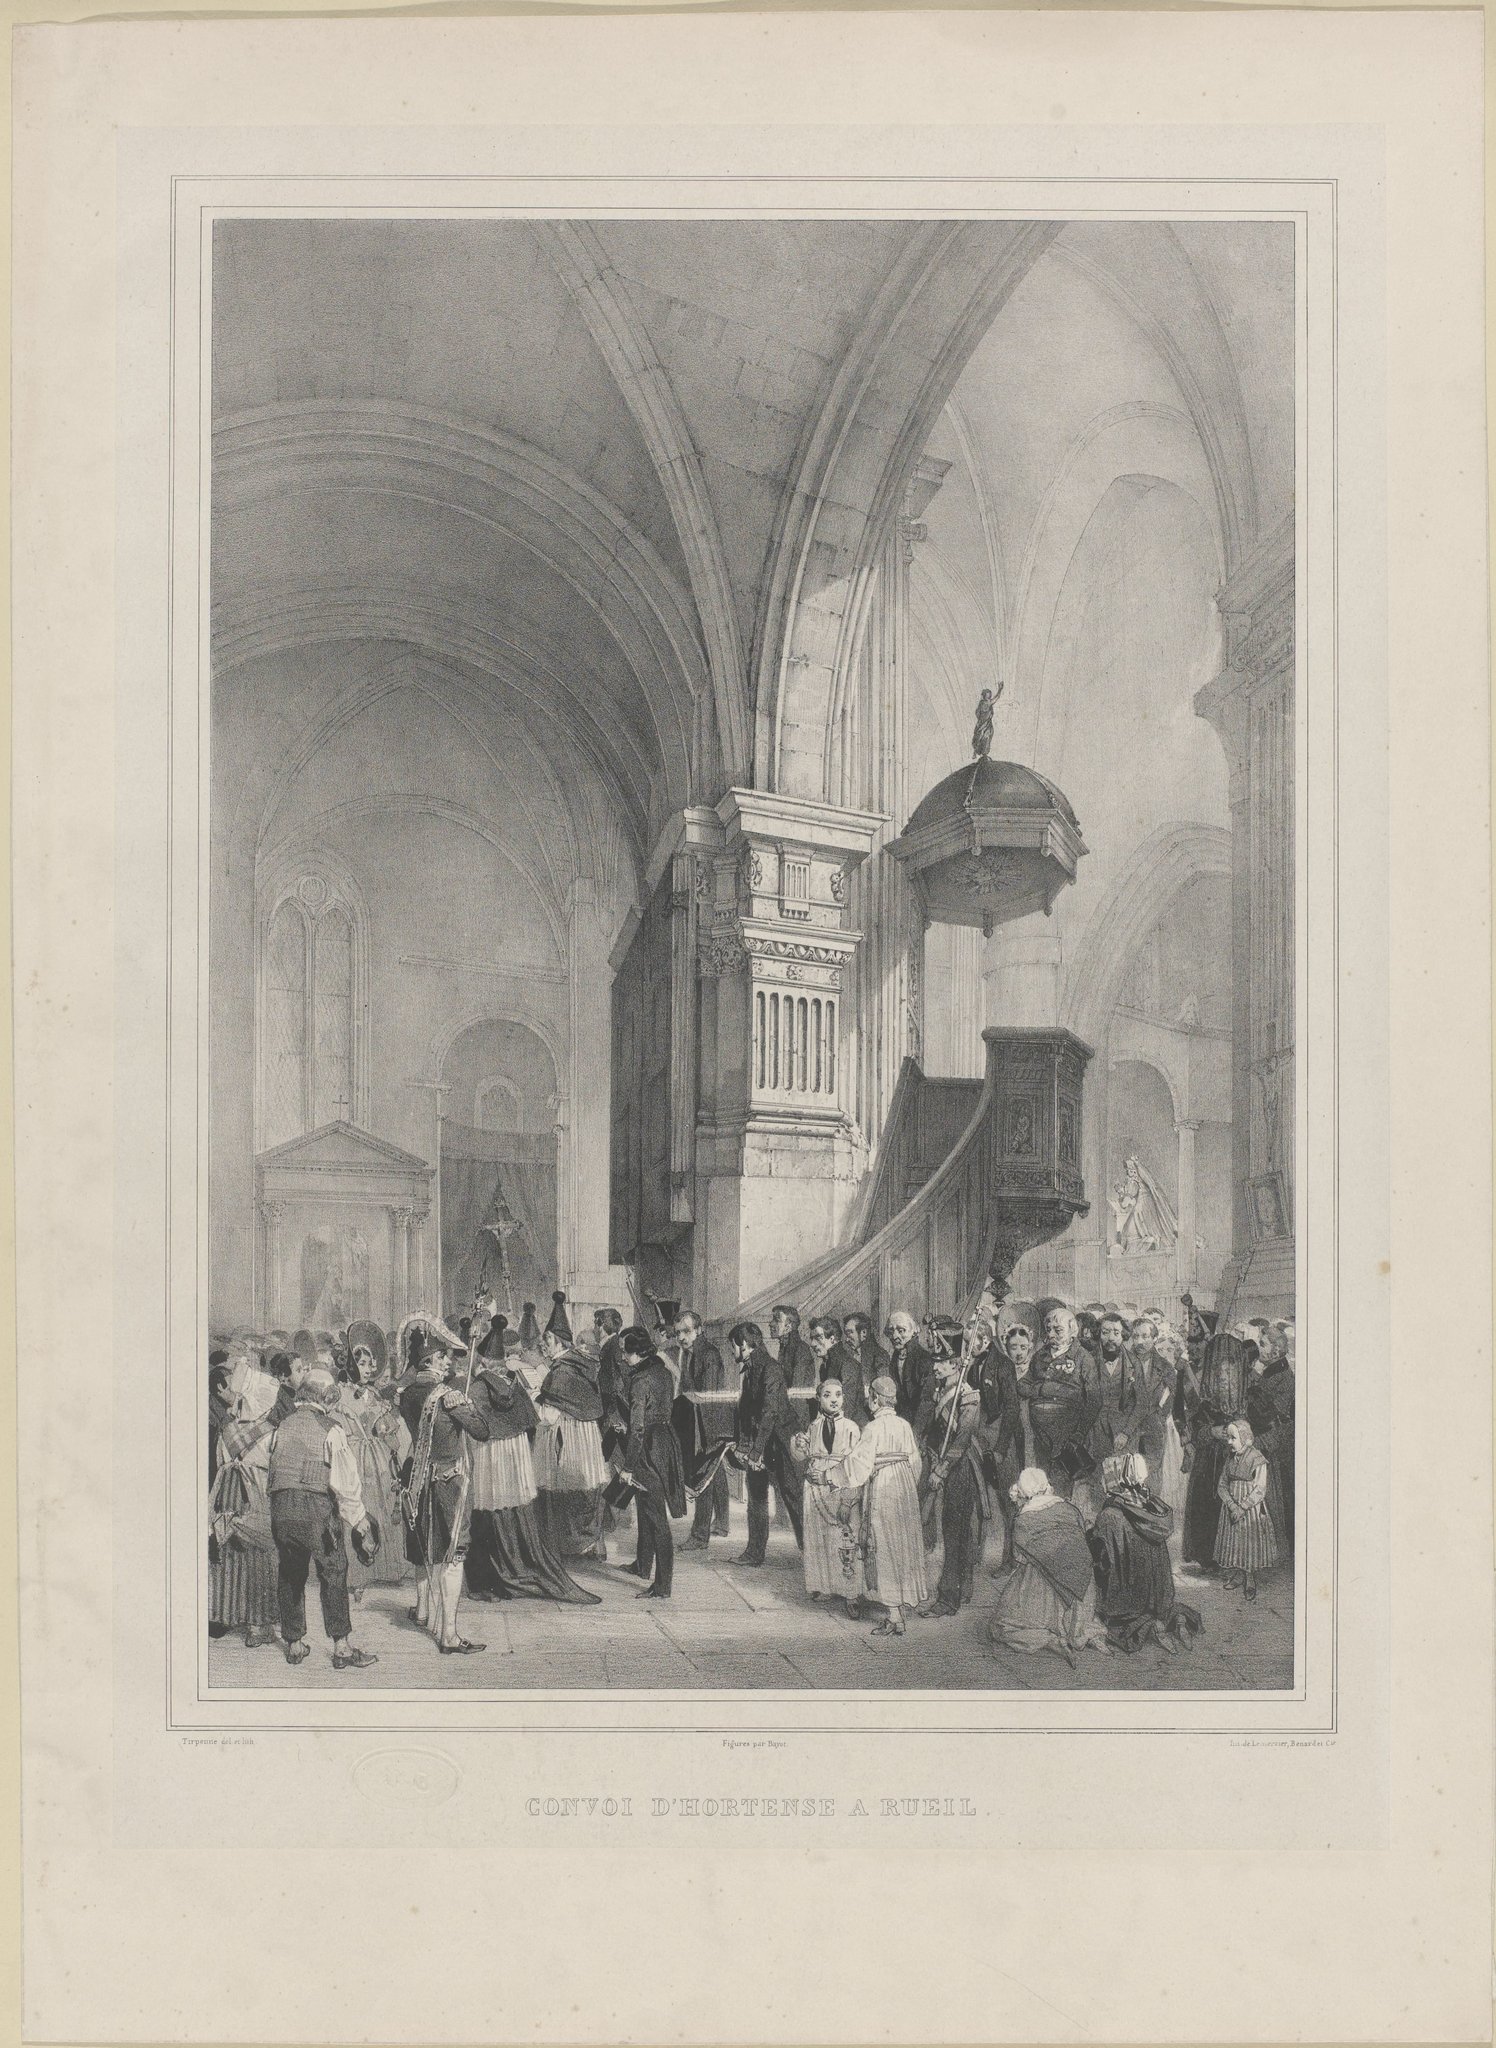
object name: print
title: Convoi d'Hortense a Rueil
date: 1837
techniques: printmaking, lithograph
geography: france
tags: funerary ceremonial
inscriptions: collector's mark:, collector's mark: Lugt 2228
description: Begrafenis van Hortense de Beauharnais, echtgenote van koning Lodewijk Napoleon, in de kerk Saint-Pierre-Saint-Paul te Rueil-Malmaison, 19 november 1837.